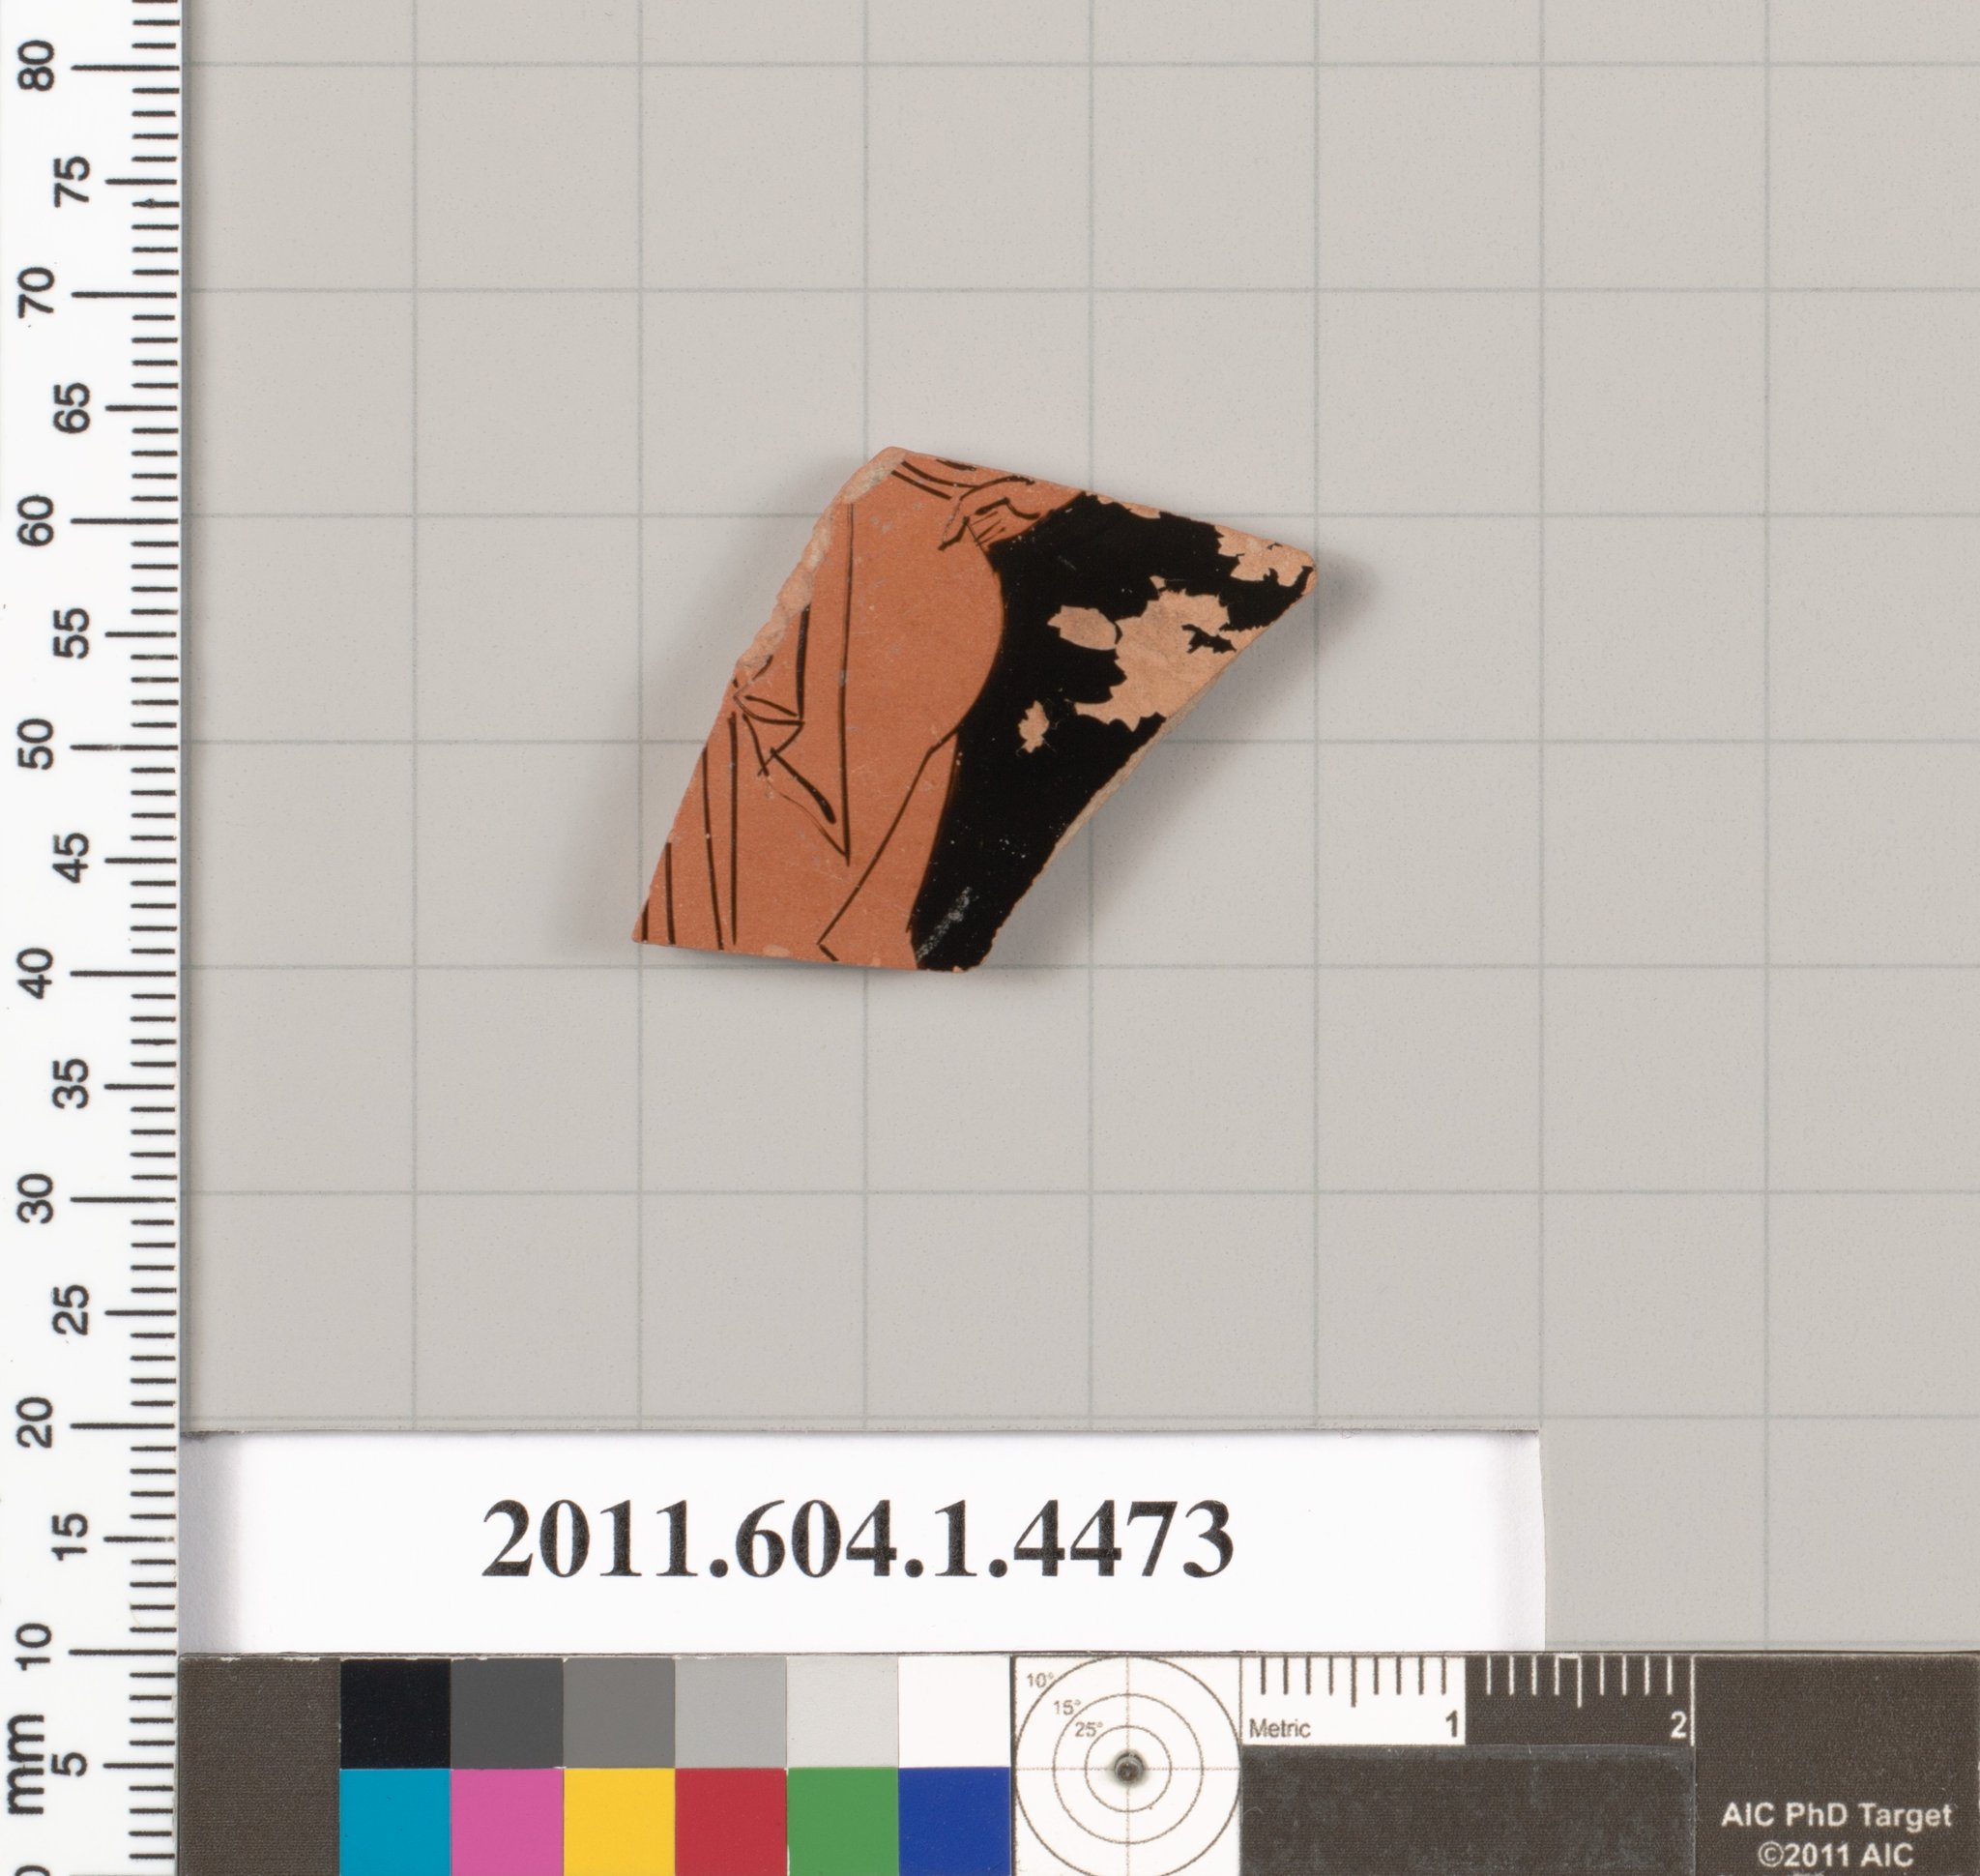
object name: kylix fragment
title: Terracotta fragment of a kylix (drinking cup)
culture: greek, attic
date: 490-470 BCE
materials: terracotta